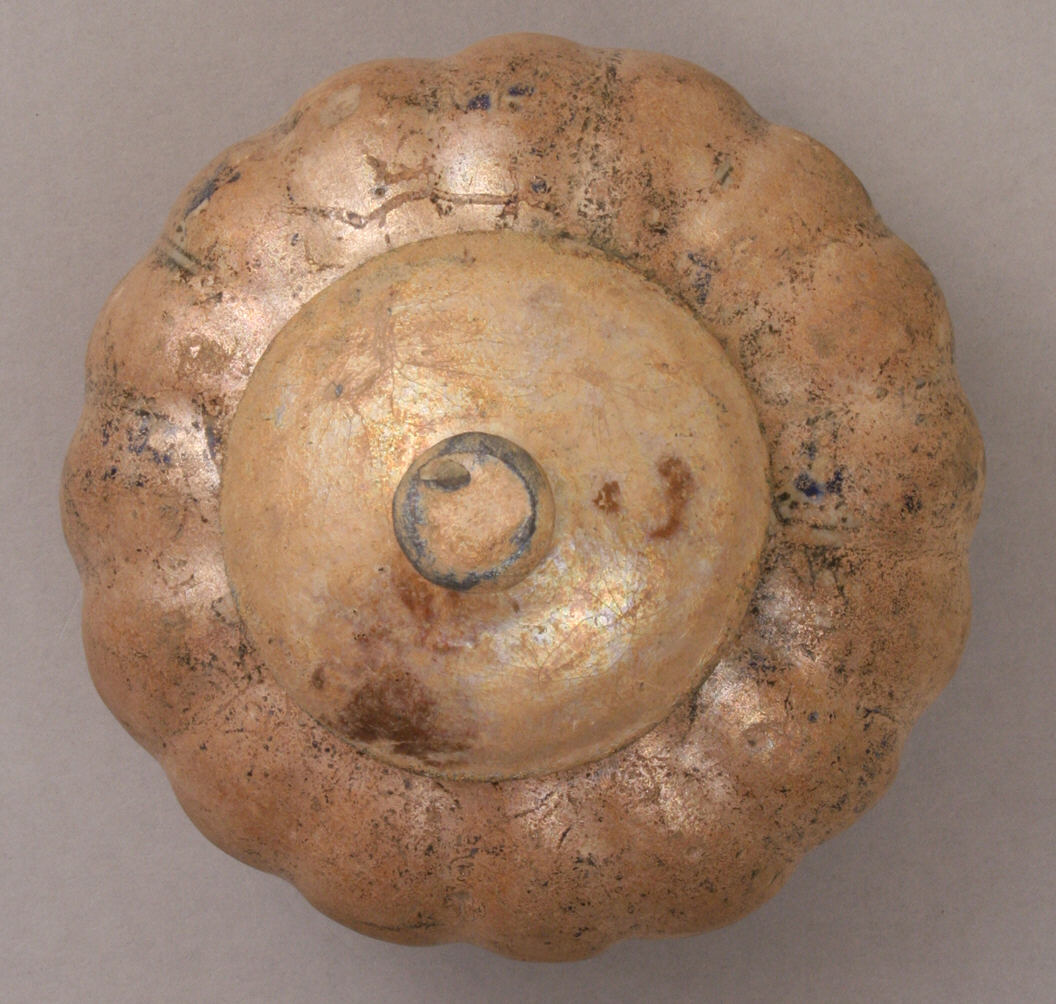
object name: jar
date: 1301-1400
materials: earthenware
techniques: glazing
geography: iran